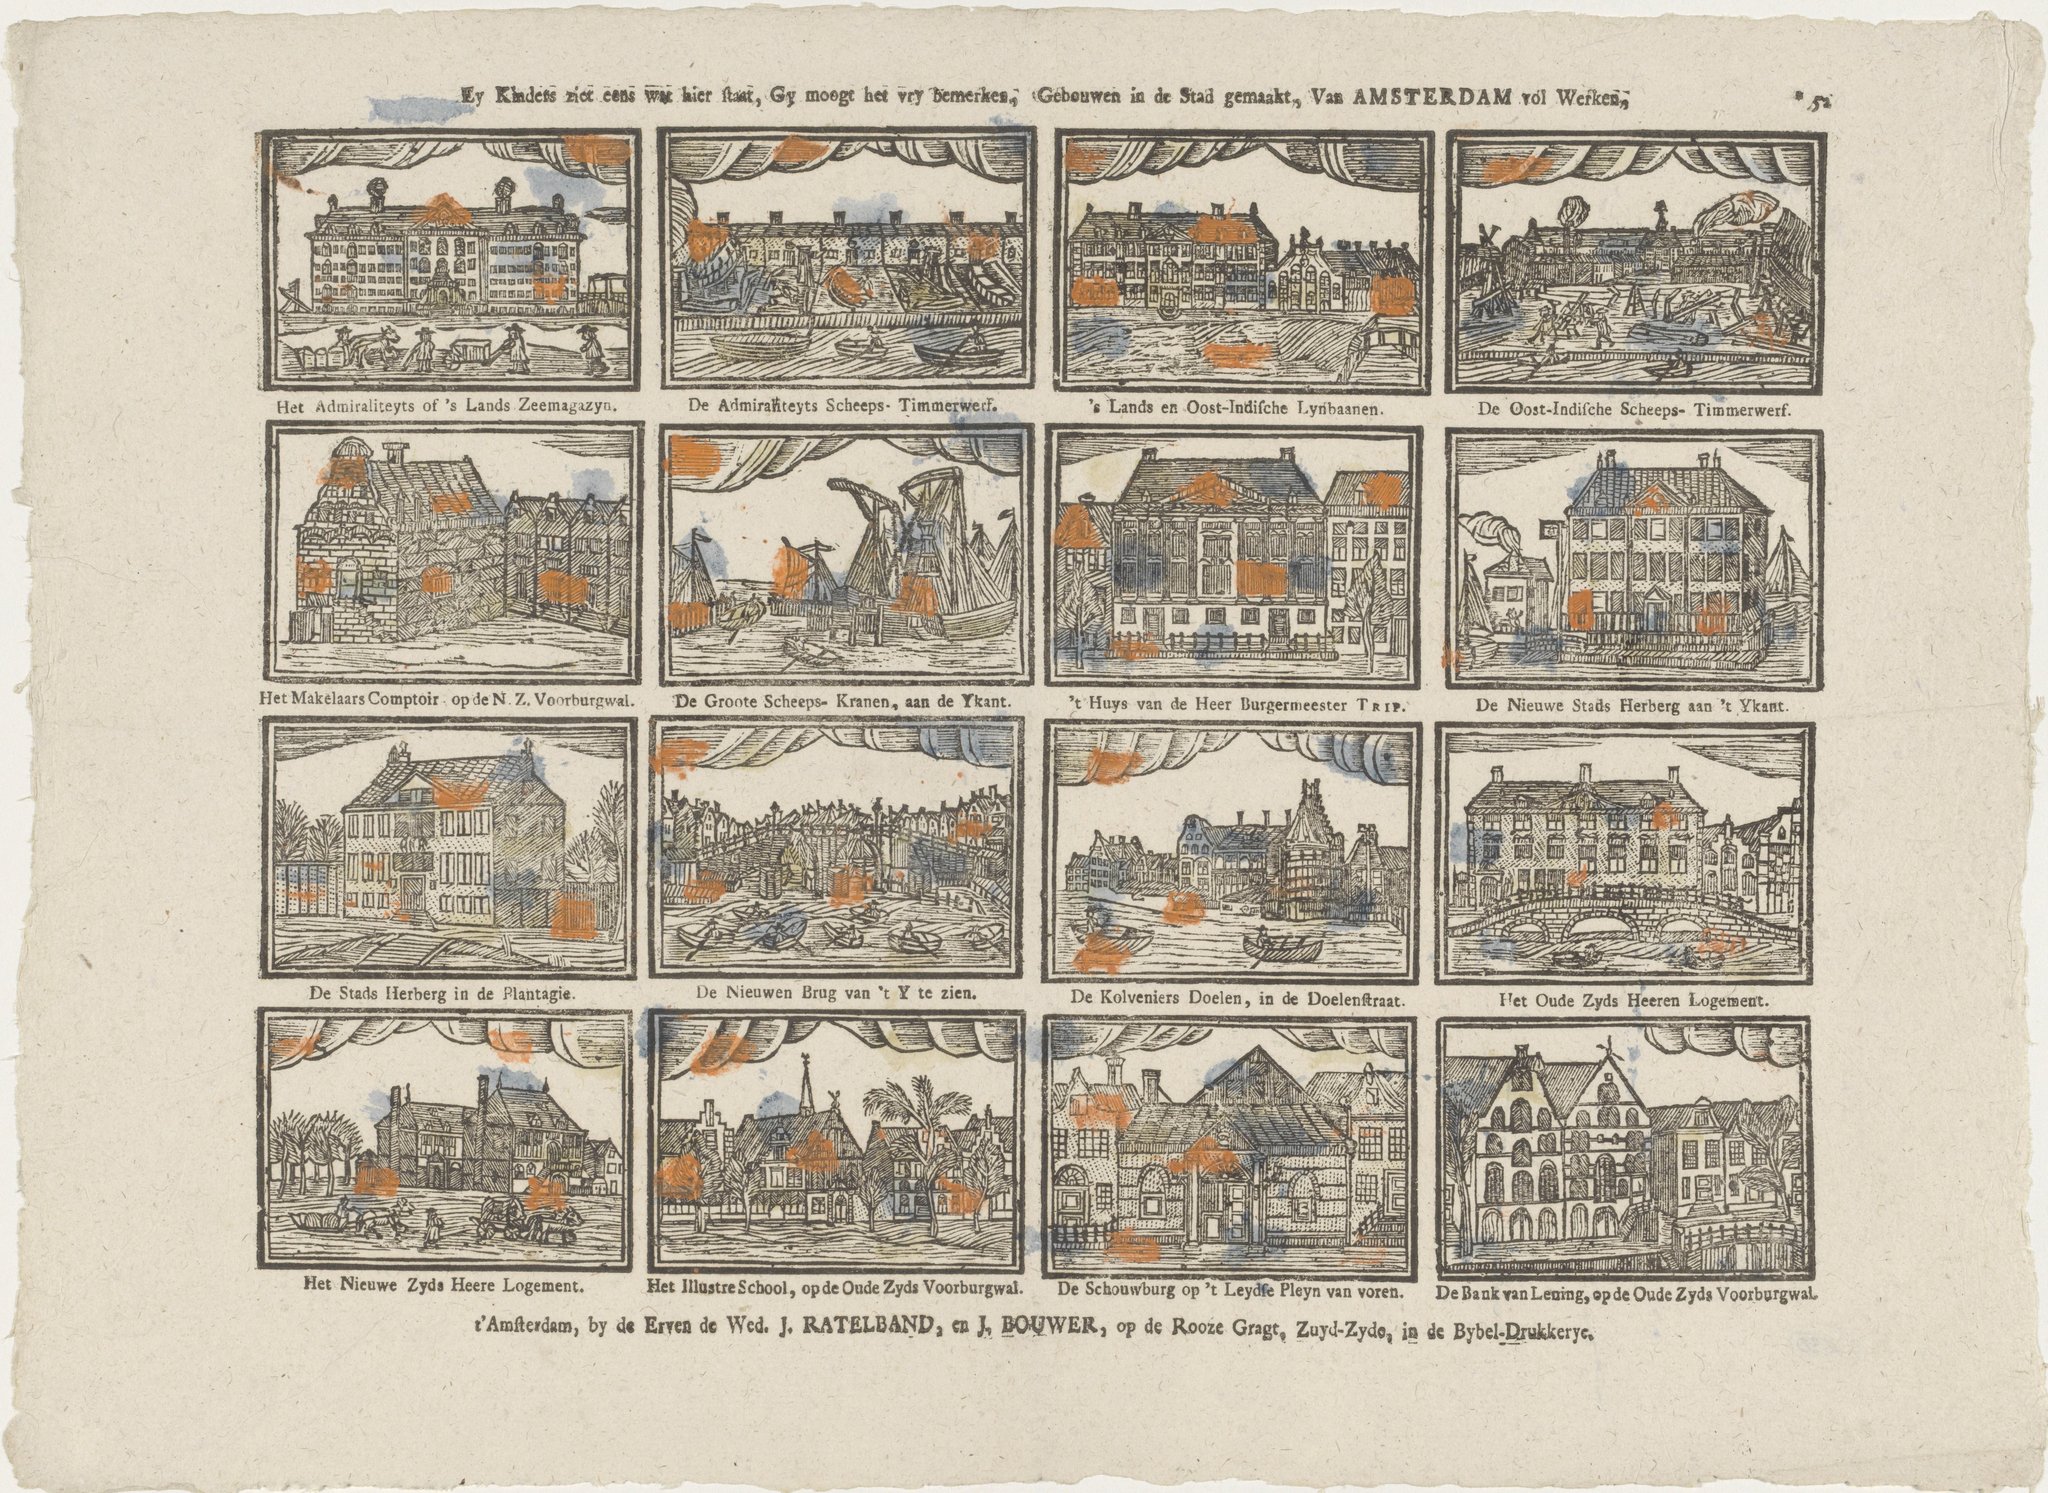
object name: print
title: Ey kinders ziet eens wat hier staat, Gy moogt het vry bemerken, Gebouwen in de stad gemaakt, Van Amsterdam vol werken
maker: Anonymous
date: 1782-1793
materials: paper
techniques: colour, letterpress printing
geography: netherlands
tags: exterior ~ representation of a building, amsterdam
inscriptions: collector's mark: Lugt 2760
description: Blad met 16 voorstellingen van gebouwen, werven en logementen in Amsterdam. Onder elke voorstelling een onderschrift. Genummerd rechtsboven: *52.